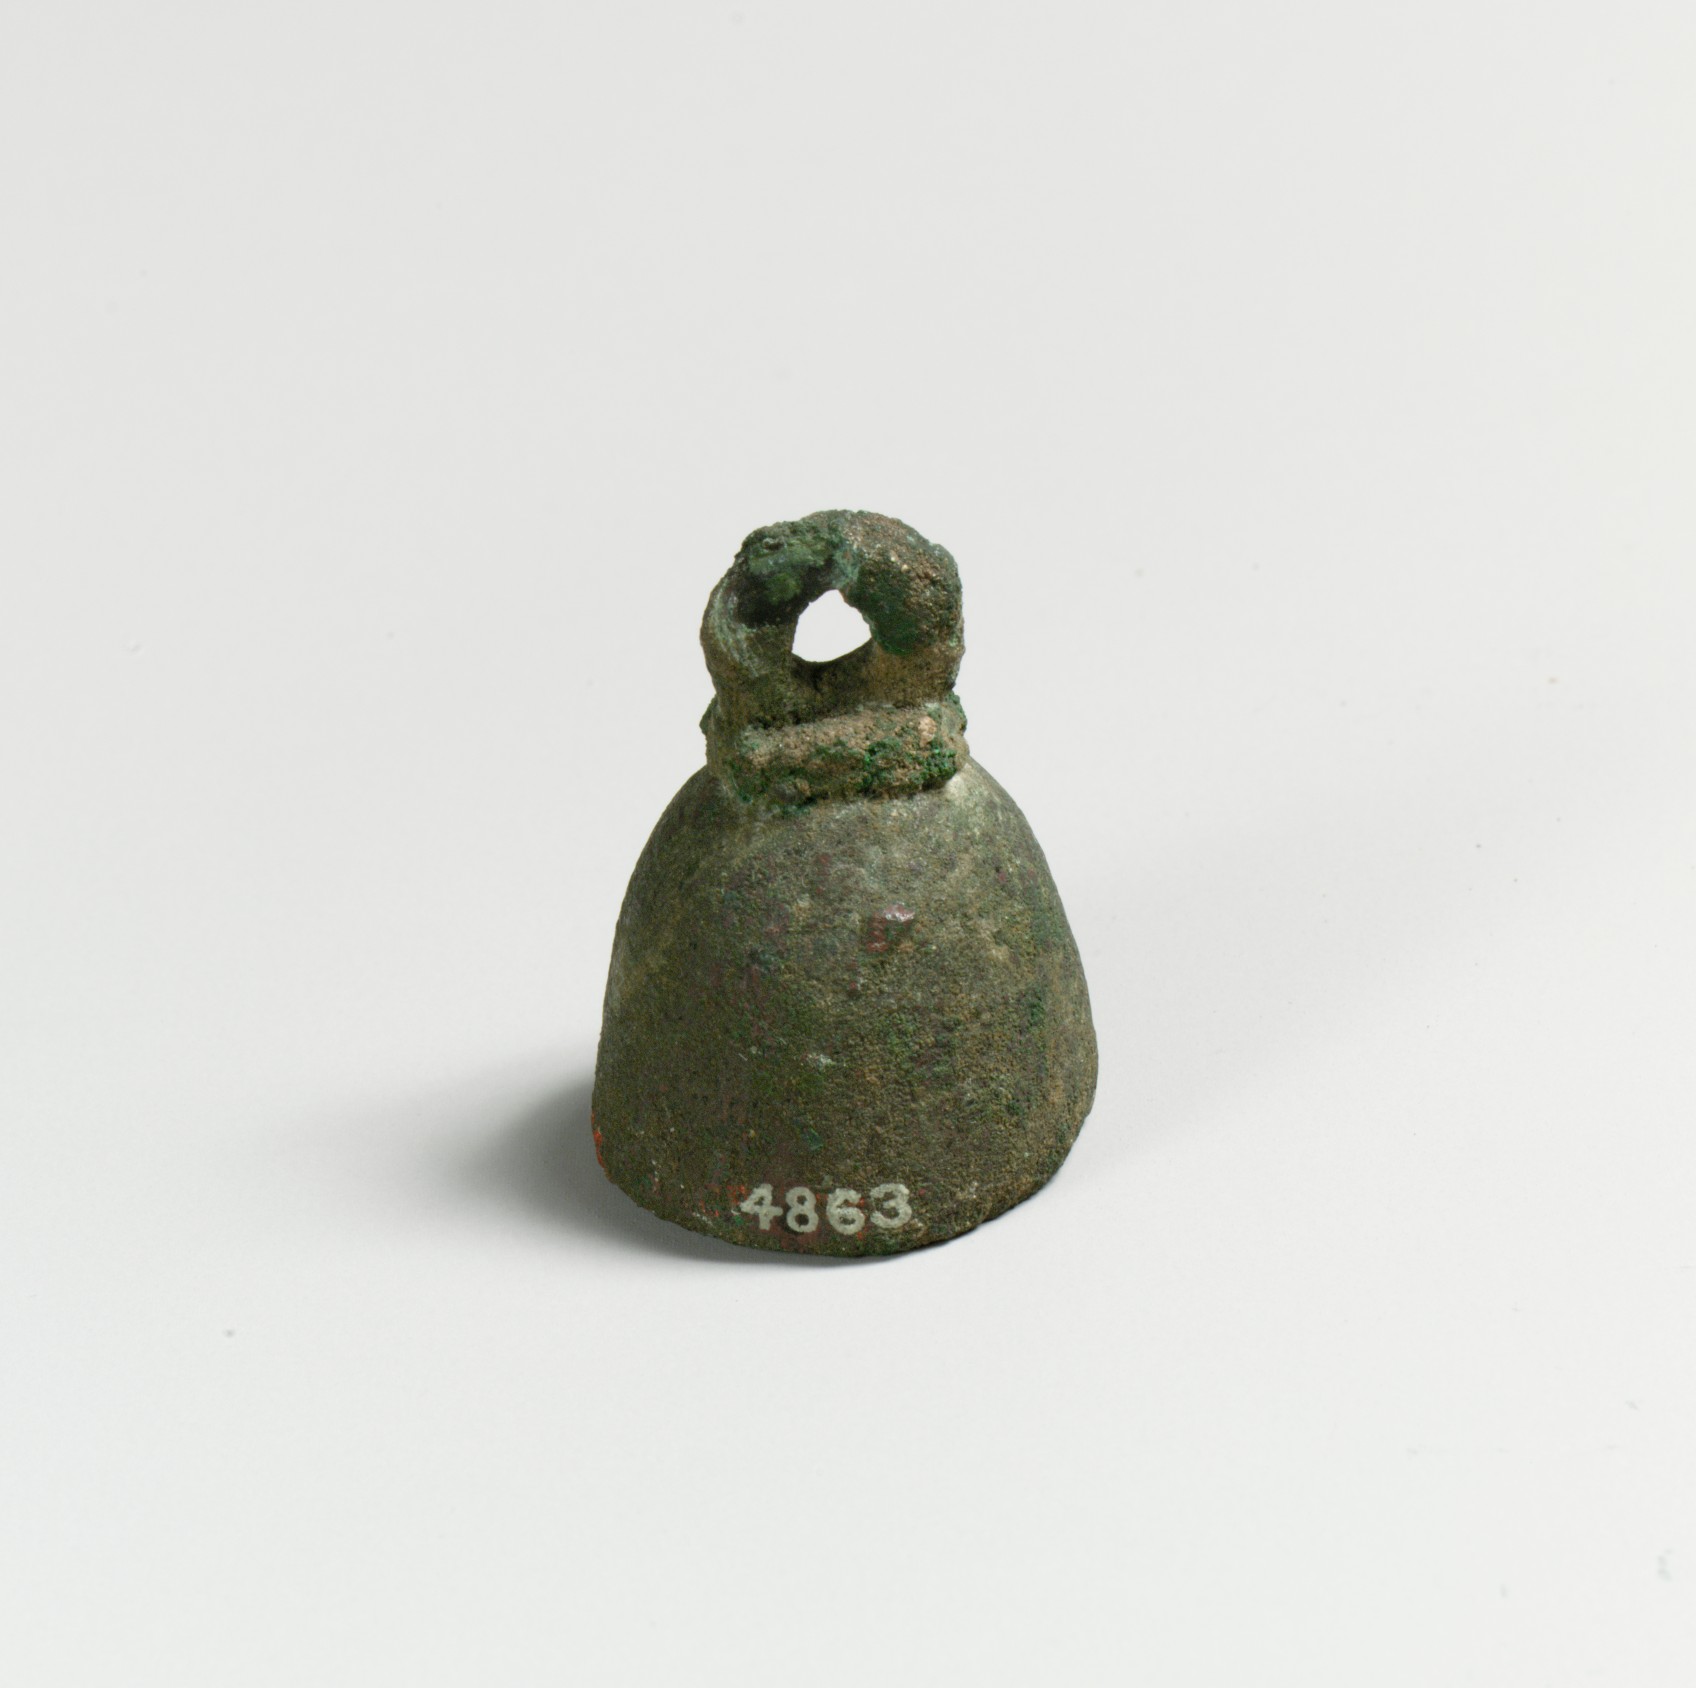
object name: bell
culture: cypriot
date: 400-301 BCE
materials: bronze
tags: musical instruments